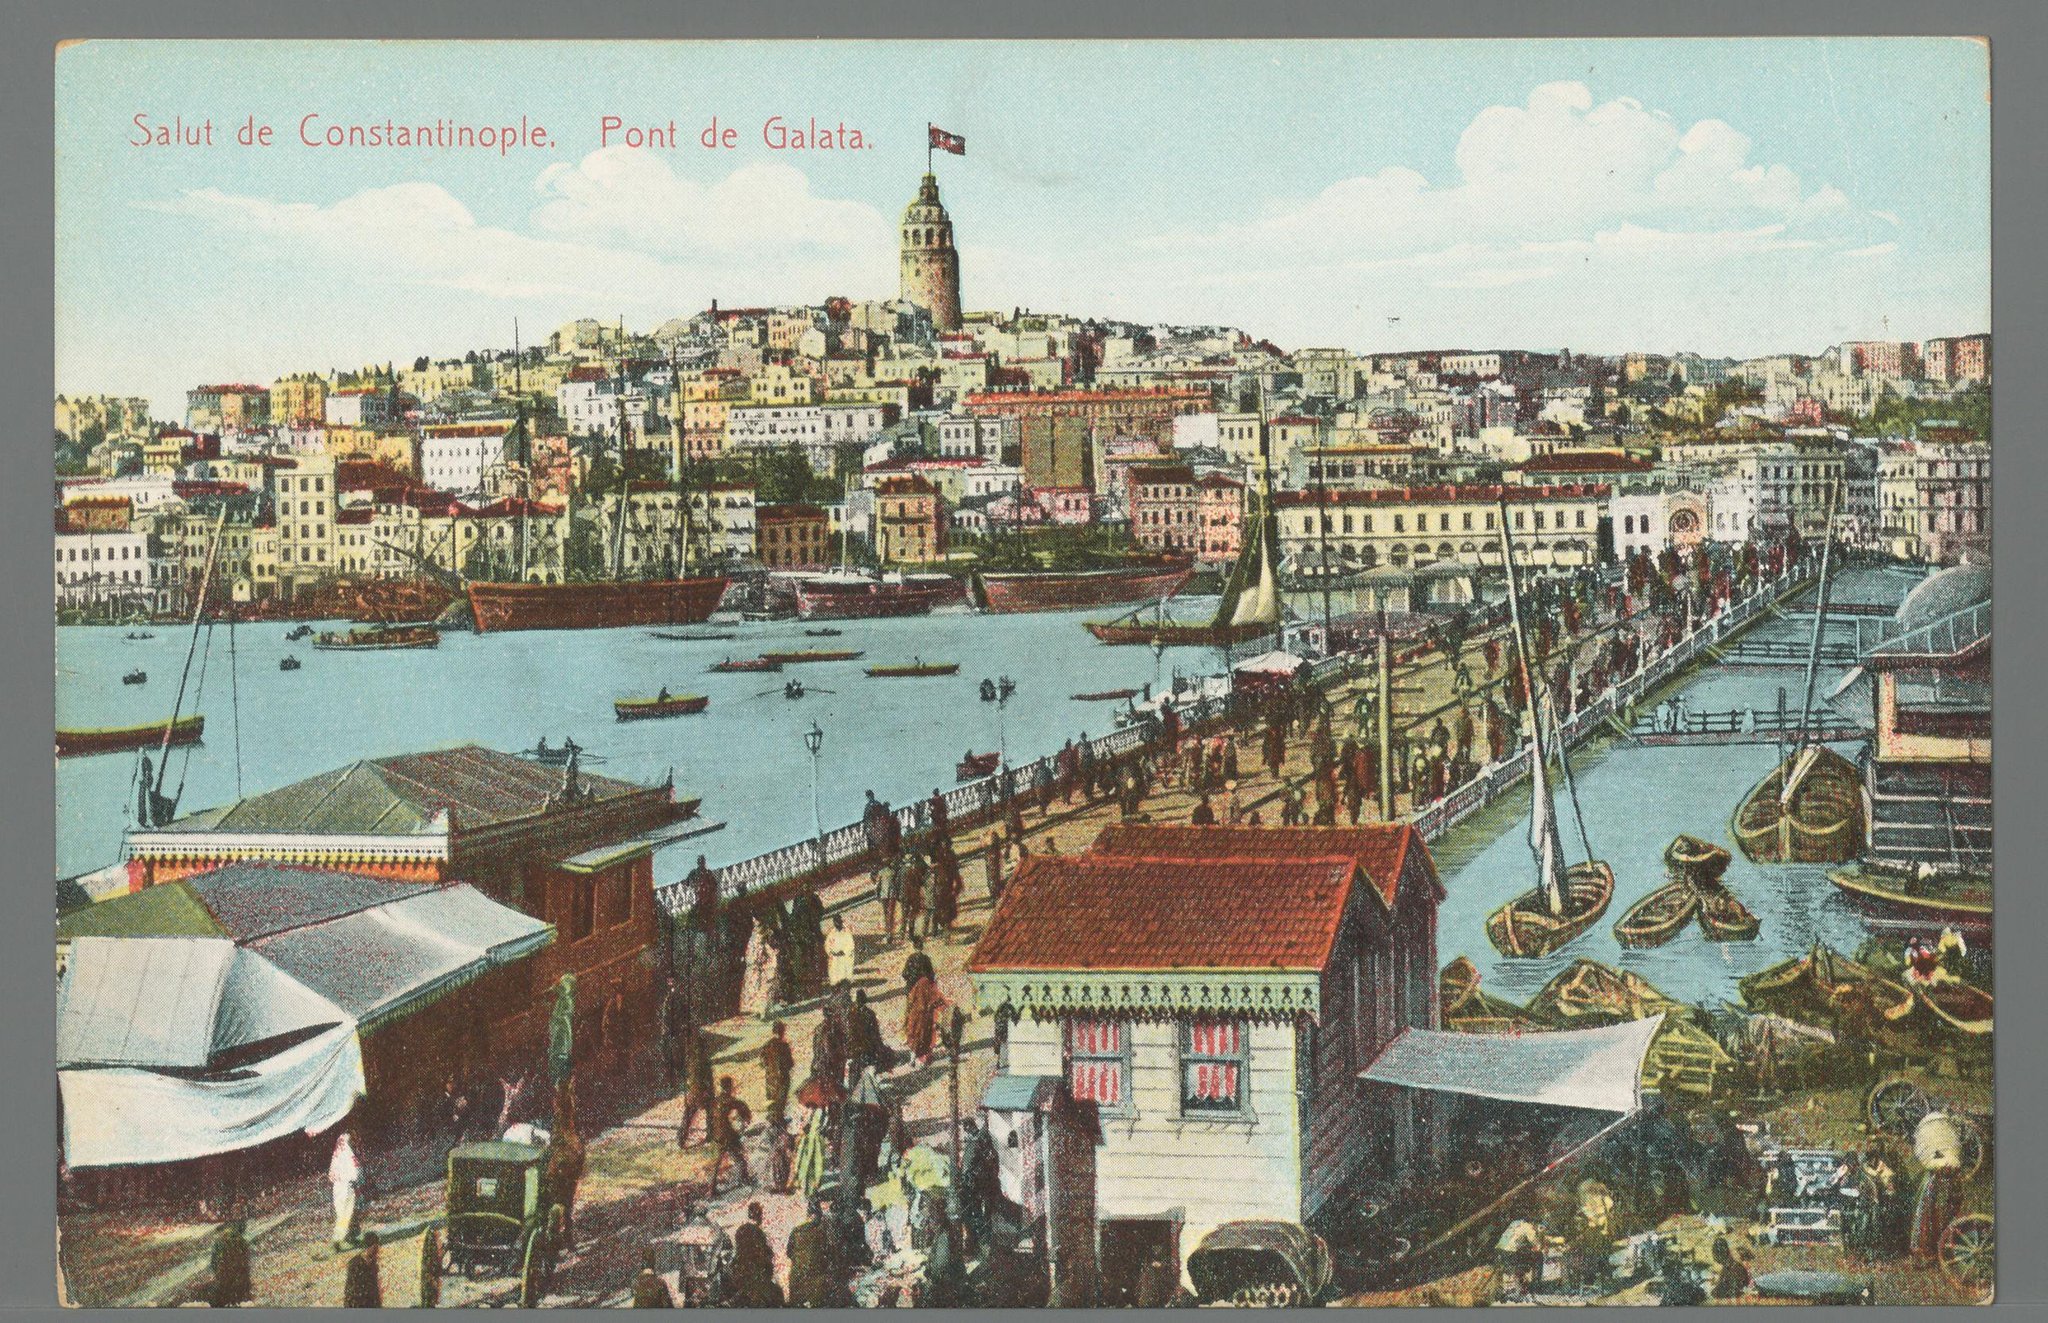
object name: photomechanical print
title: Salut de Constantinople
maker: Anonymous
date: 1906-1920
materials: cardboard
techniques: lithograph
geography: constantinople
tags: bridge in city across river, canal, etc. (+ city(-scape) with figures, staffage), city-view, and landscape with man-made constructions (+ city(-scape) with figures, staffage)